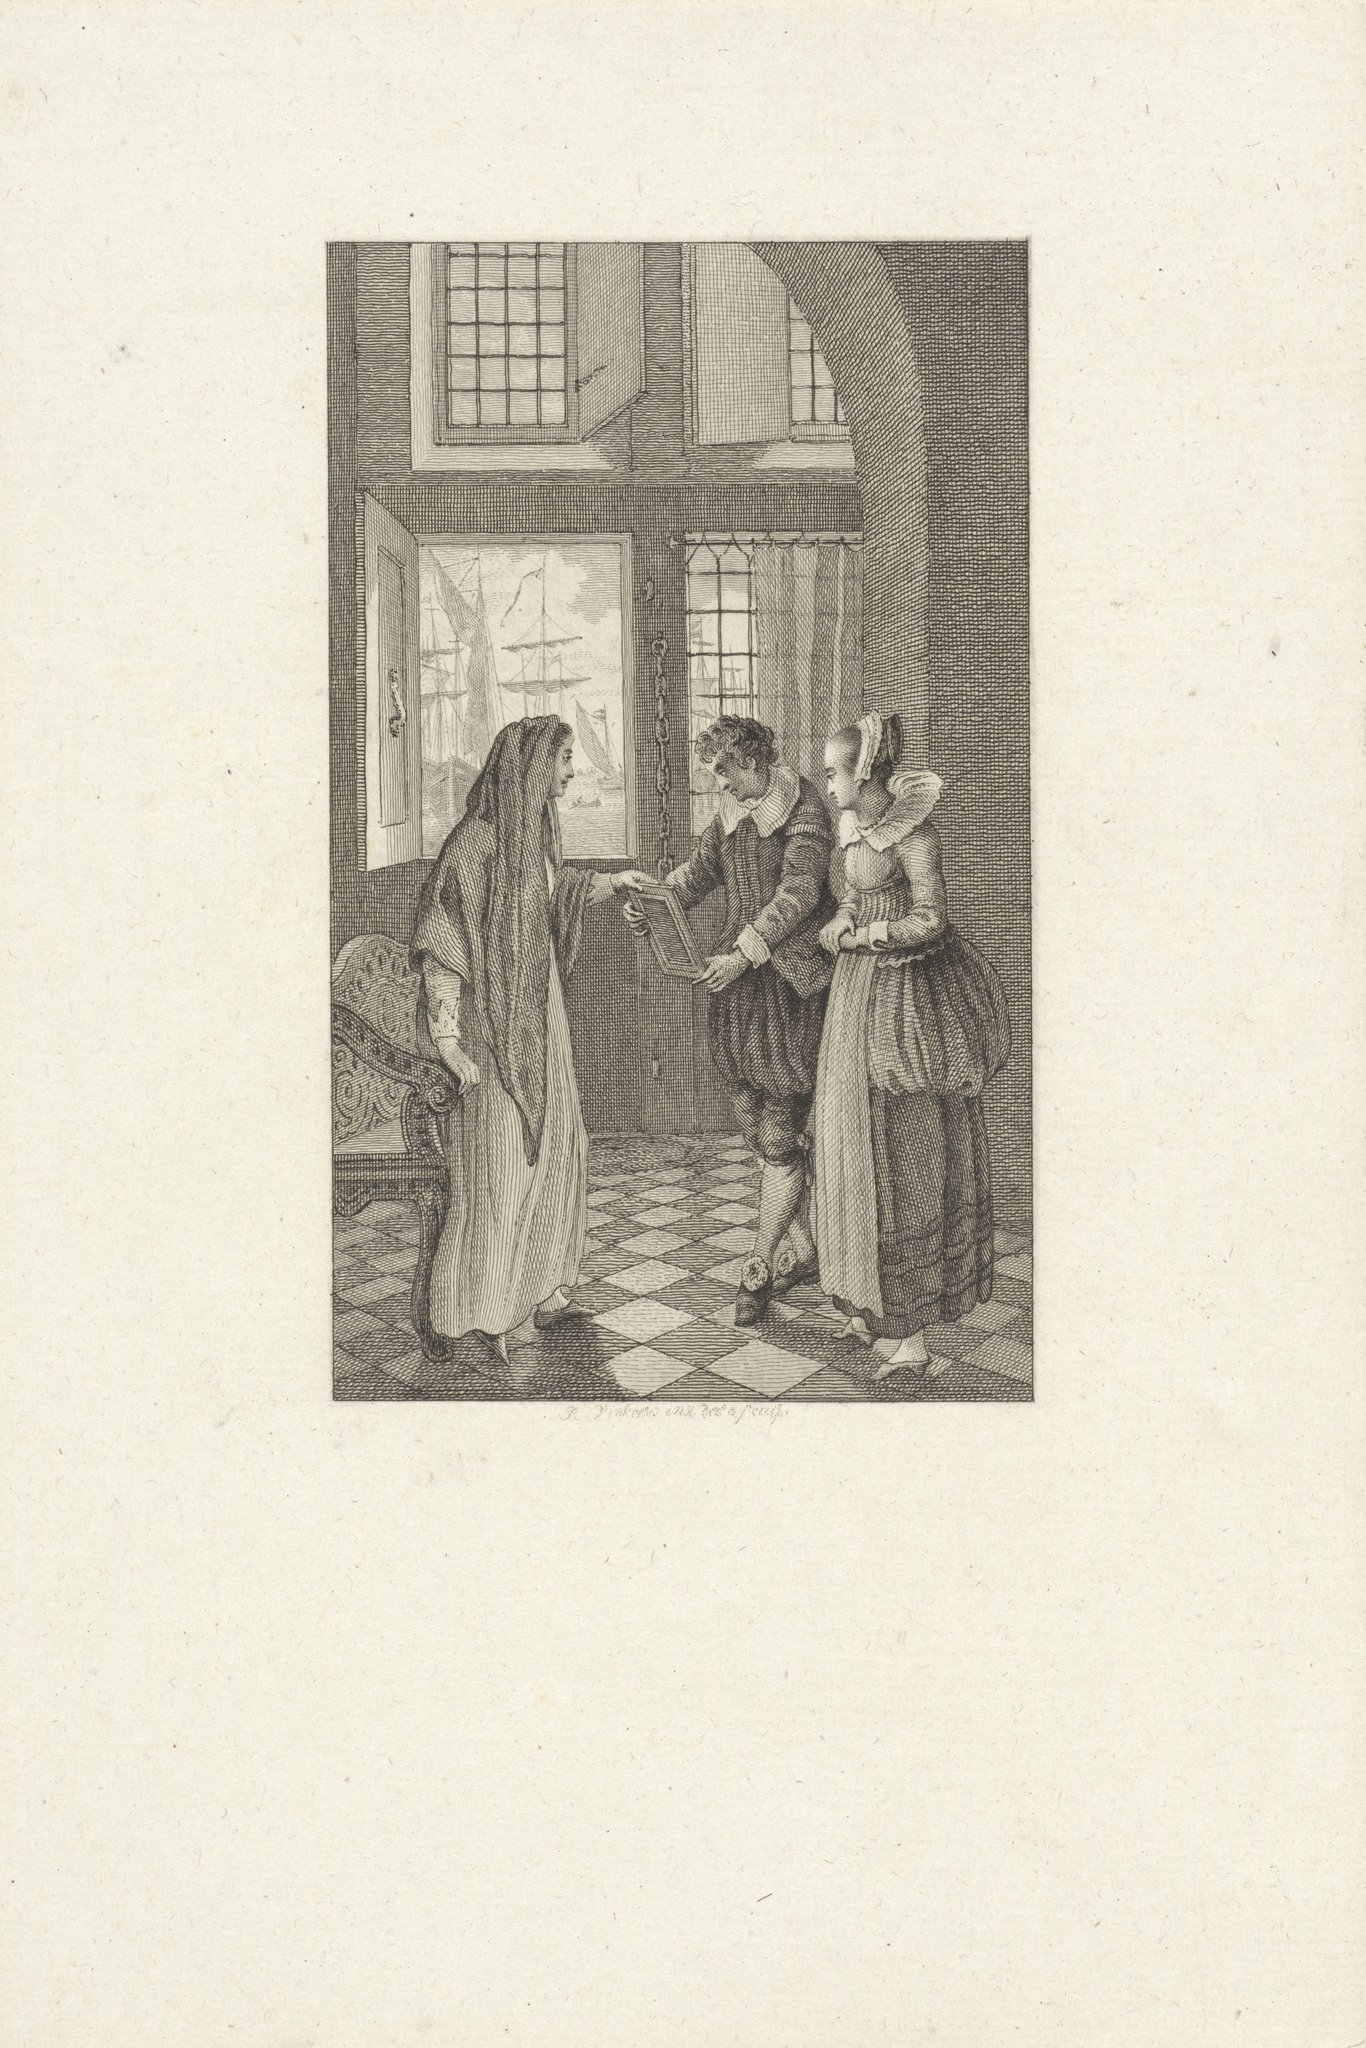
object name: print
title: Vrouw toont een man een portret, mogelijk van Antonia Manichetti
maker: reinier vinkeles (i)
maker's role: draughtsman, print maker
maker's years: 1741-1816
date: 1751-1816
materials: paper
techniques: engraving, etching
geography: amsterdam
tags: sailing-ship, sailing-boat, anonymous historical person portrayed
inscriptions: collector's mark: Lugt 2228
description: Proefdruk van illustratie voor: Loosjes, Adriaan Pietersz. Het leven van Maurits Lijnslager : eene Hollandsche familiegeschiedenis uit de zeventiende eeuw. Haarlem: Adriaan Pietersz. Loosjes, 1808, p. 309.